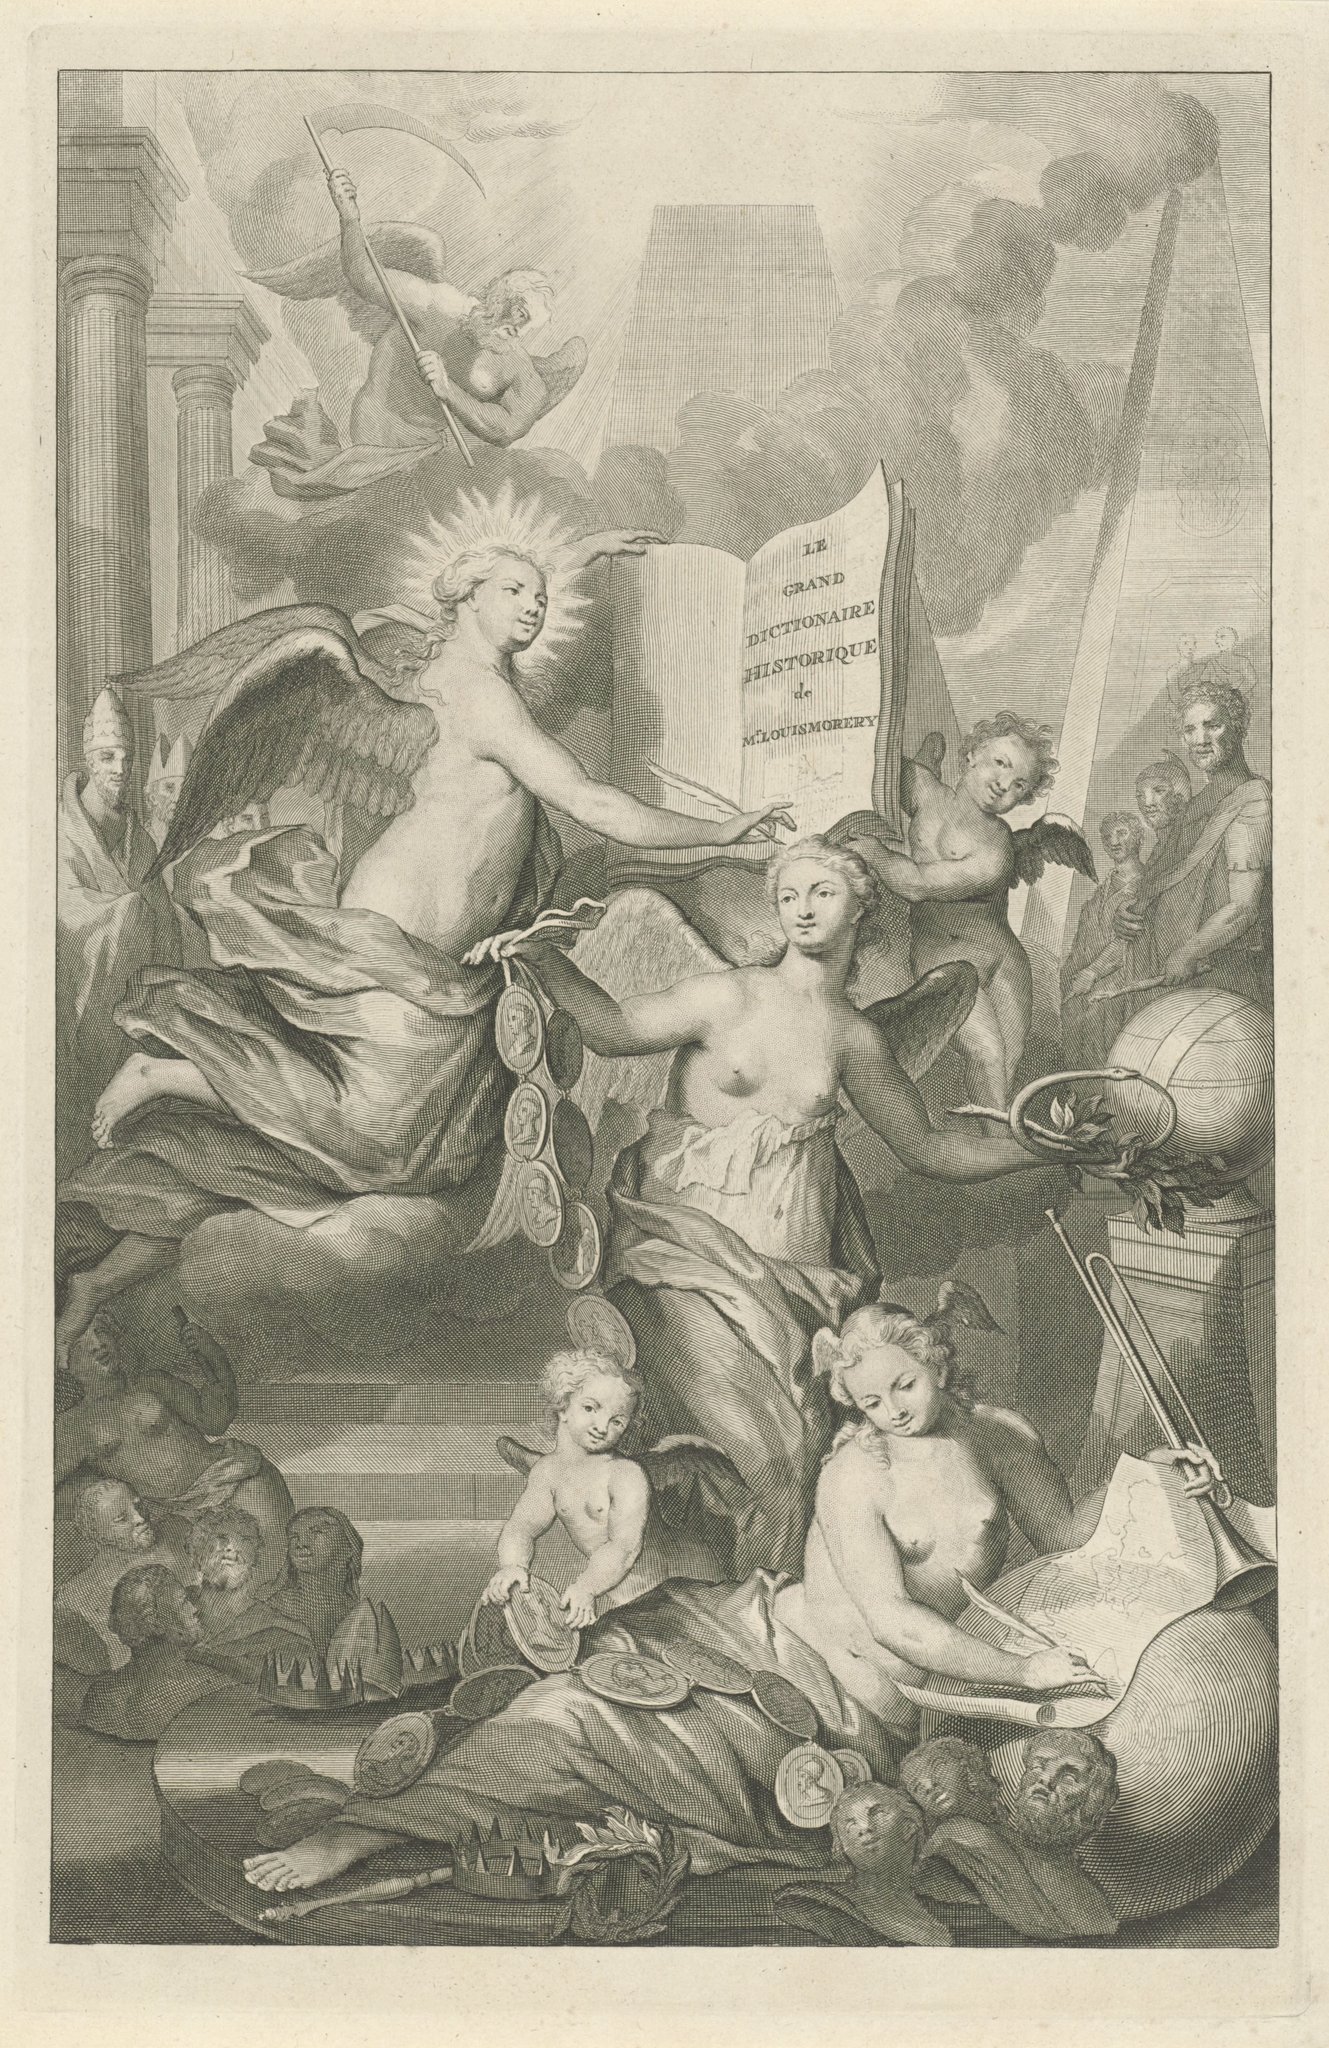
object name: print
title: Titelpagina voor Louis Moréri, Le grand dictionaire historique, 1731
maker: pieter van gunst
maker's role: print maker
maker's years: 1658-1731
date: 1731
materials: paper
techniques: engraving, etching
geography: amsterdam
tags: eternity, 'aeternitas'; 'eternità','eternità o perpetuità' (ripa), serpent ouroboros, fame; 'fama', 'fama buona', 'fama chiara' (ripa), father time, man with wings and scythe, 'litterae', symbolic representations, allegories and emblems ~ literature; 'lettere' (ripa)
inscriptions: collector's mark: Lugt 2228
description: In het midden drie gevleugelde personificaties: Faam ligt op de voorgrond en tekent een kaart. Ze kijkt naar een medaillonketting met portretten van vorsten; Eeuwigheid draagt in de ene hand een medaillonketting met portretten en in de andere hand het teken van oneindigheid, de ring Ouroboros. Links zit Schrijfkunst. Zij schrijft alles op in een groot boek, waarop de titel van het boekwerk. Rondom hen belangrijke figuren uit de geschiedenis, zoals pausen en koningen. Op de achtergrond de gevleugelde Tijd met een zeis.